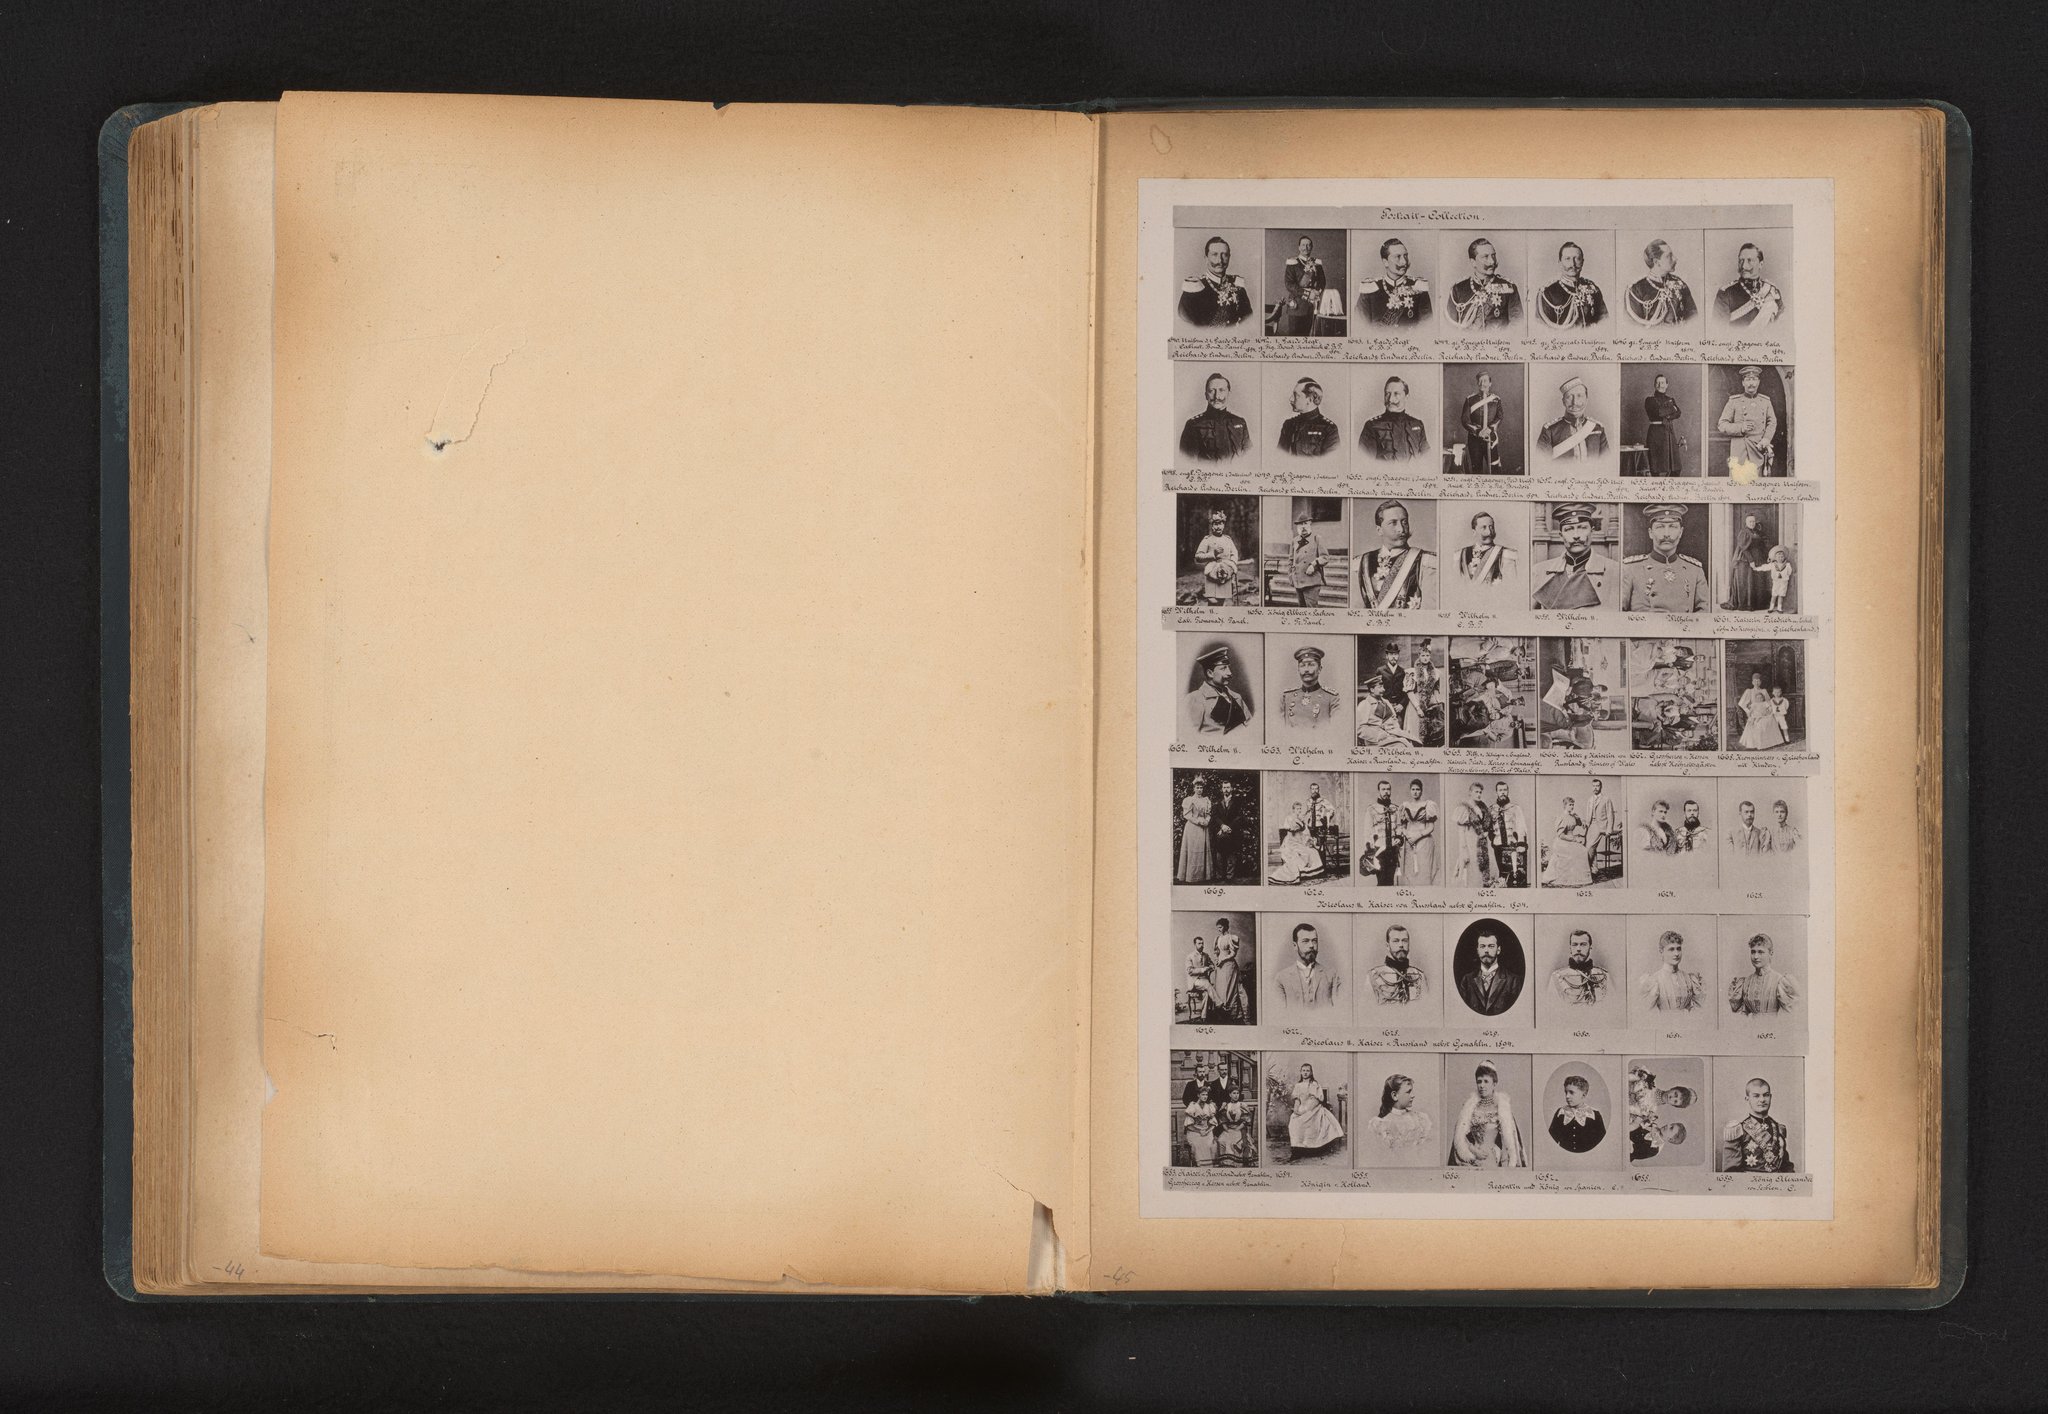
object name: page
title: Portretten van keizer Wilhelm II, tsaar Nicolaas II en diens naaste familieleden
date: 1880-1885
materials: paper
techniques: photograph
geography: berlin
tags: wilhelm ii (keizer van duitsland), ruler, sovereign, family of the sovereign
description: Prent op vijfenveertigste ongenummerde pagina.